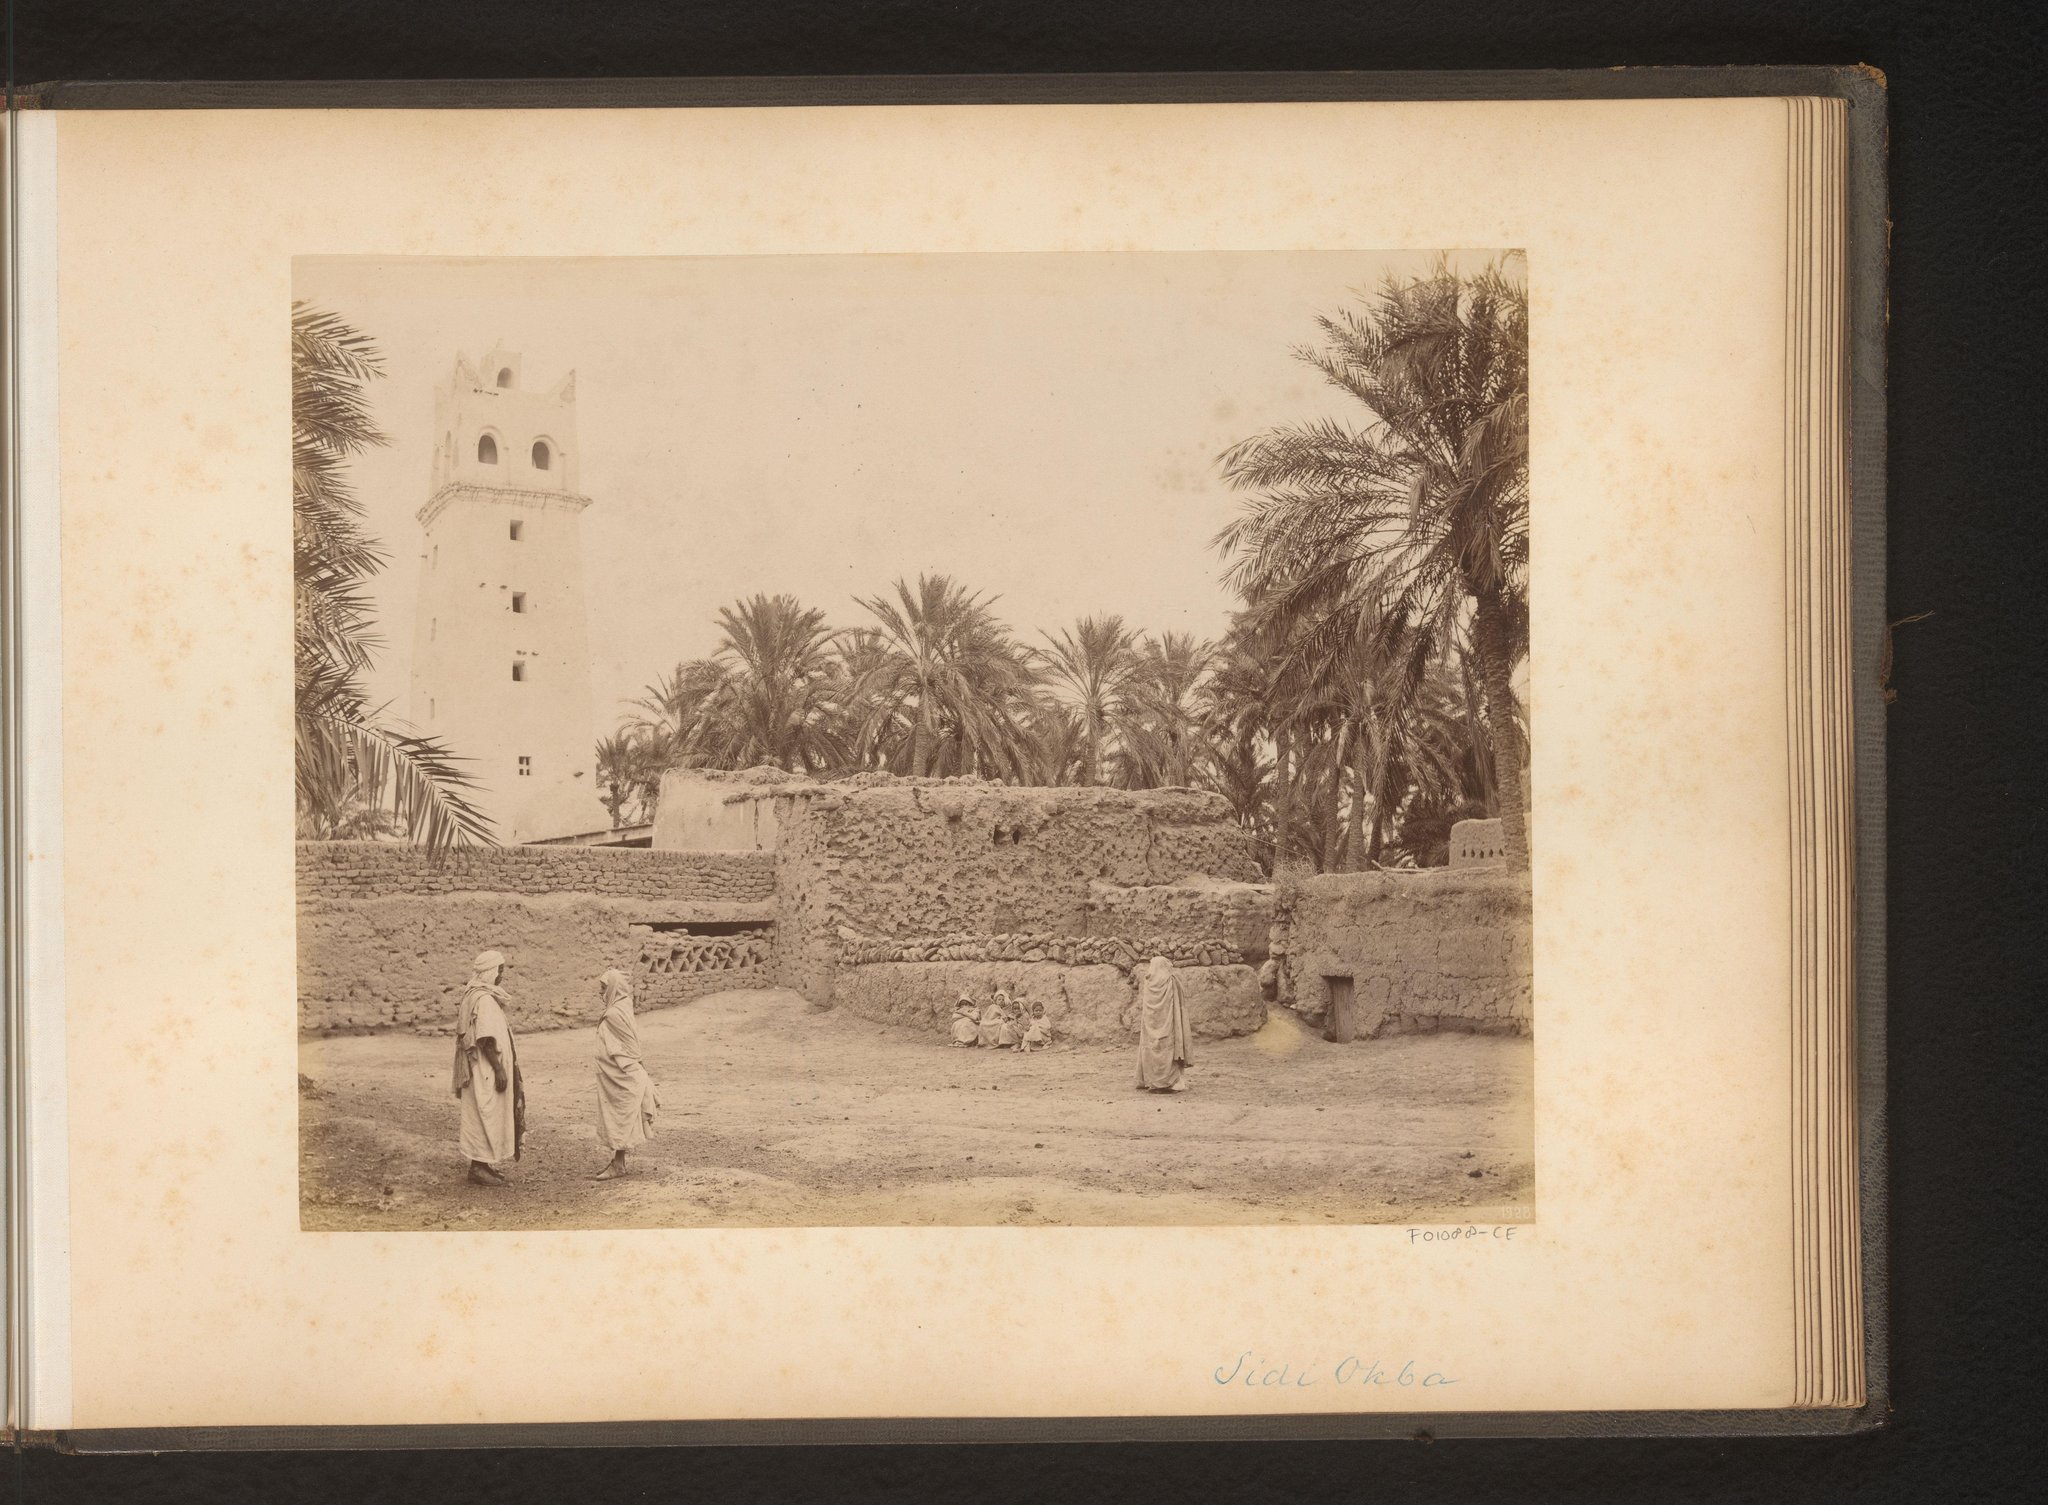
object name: album leaf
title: Personen bij een muur met op de achtergrond een toren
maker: Anonymous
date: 1880-1890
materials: photographic support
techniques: albumen print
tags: tower, clock tower ~ monumental adornment, historical persons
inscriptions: number: ‘1928’, annotation: ‘Sidi Okba’